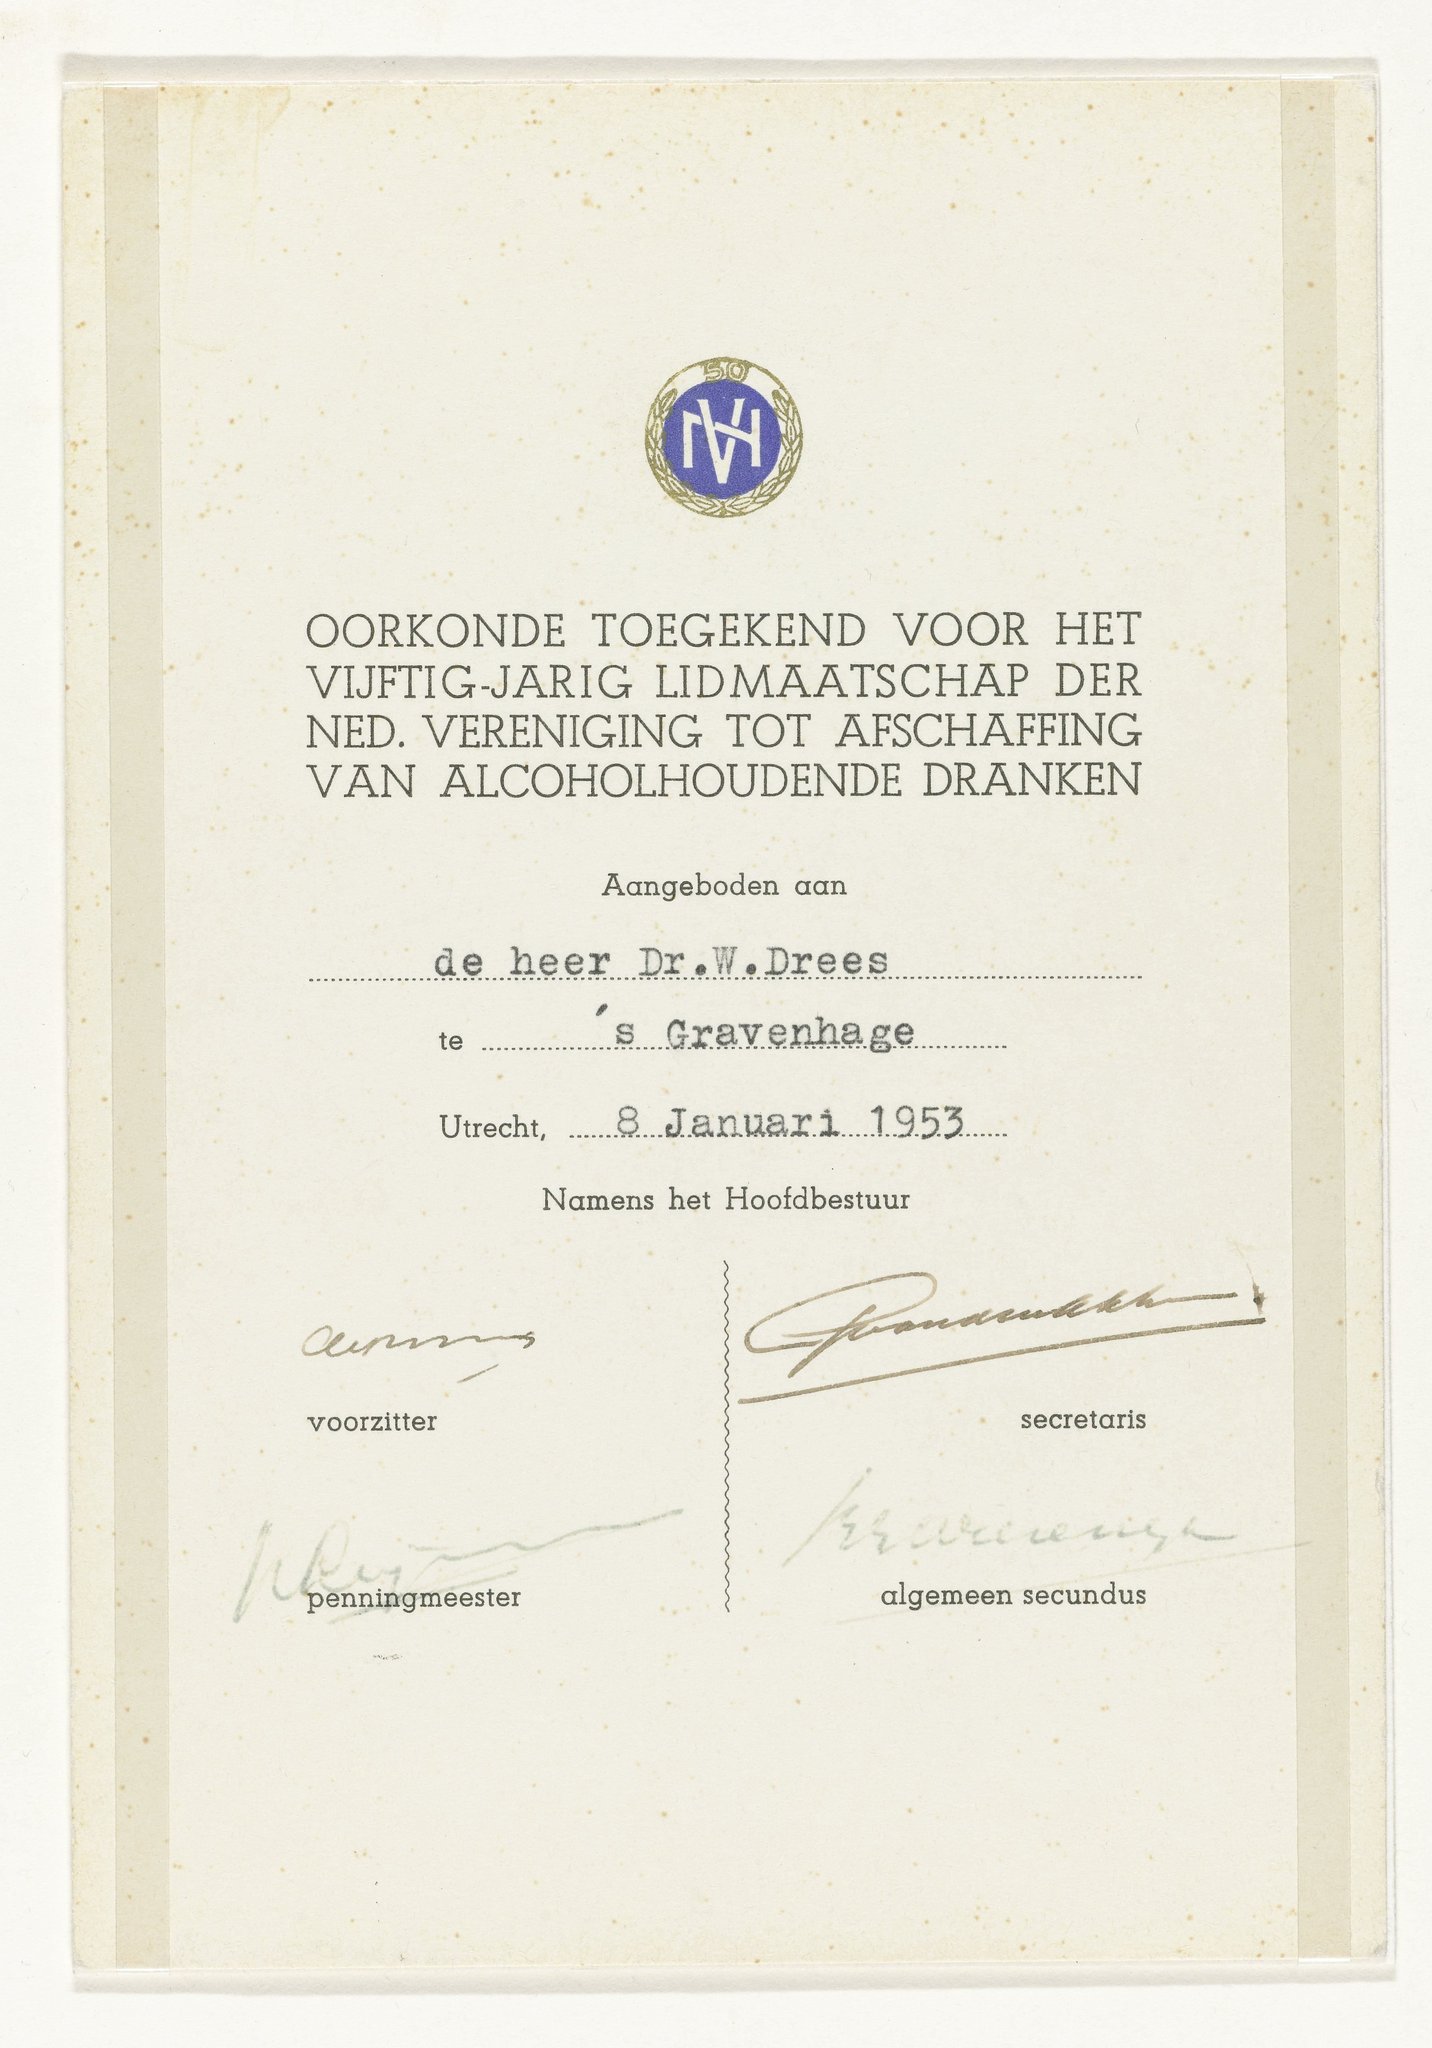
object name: charter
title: Oorkonde voor Dr. W. Drees: 50 jaar lid van de Nederlandse Vereniging tot Afschaffing van Alcoholhoudende Dranken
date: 1953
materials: ball point pen, cardboard, ink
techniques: gilding, pen, printing, typewriting, writing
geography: utrecht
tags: amsterdam, the hague, willem drees, netherlands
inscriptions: date